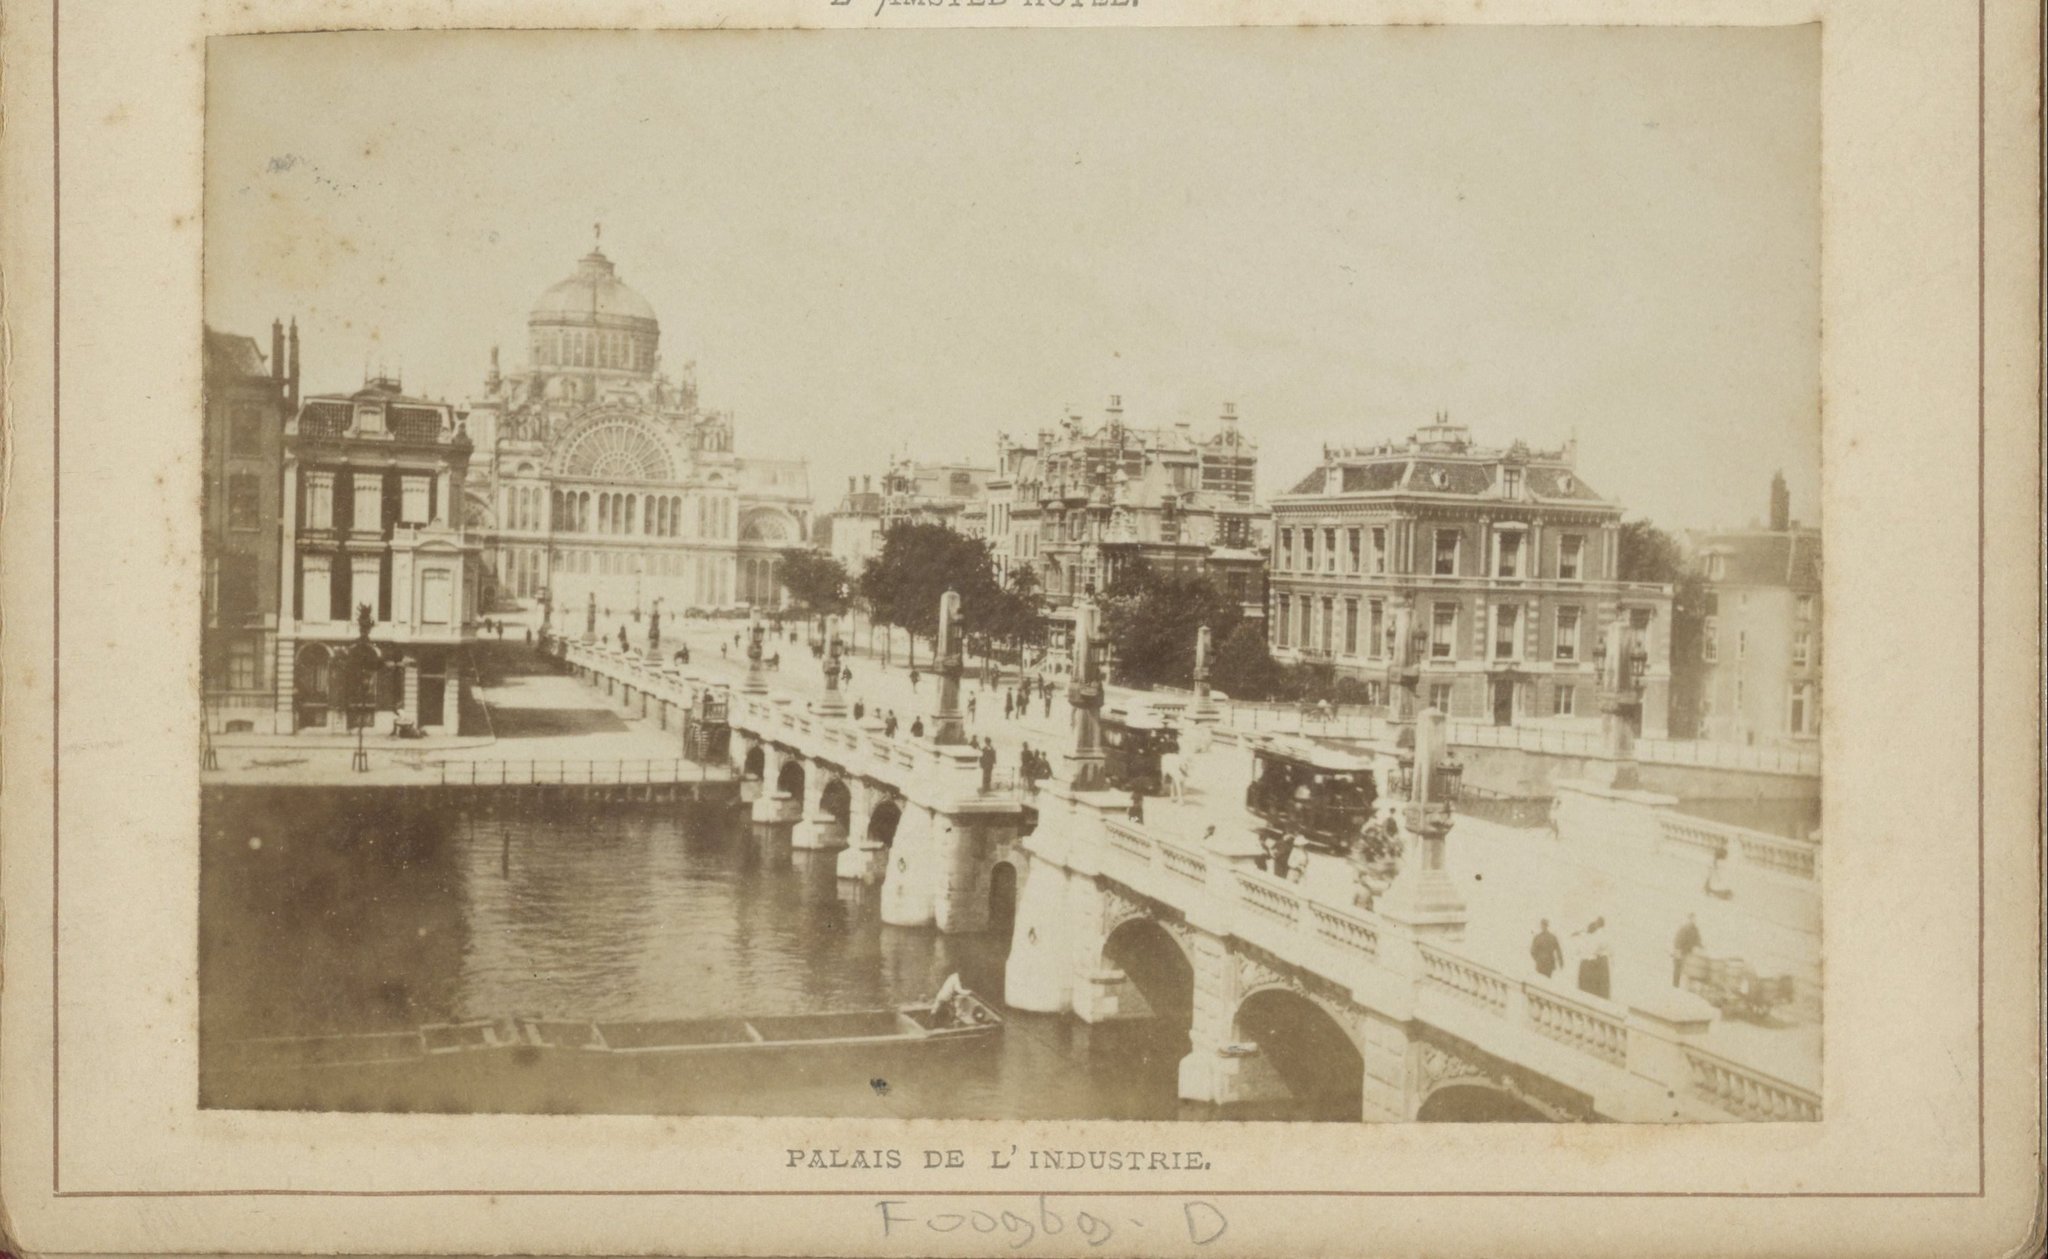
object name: photograph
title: Palais de l'Industrie.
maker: andries jager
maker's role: publisher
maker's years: 1825-1905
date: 1883-1910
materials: cardboard, paper, photographic support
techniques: albumen print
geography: amsterdam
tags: diligence, omnibus, horse-tram, palace, bridge in city across river, canal, etc., dome ~ architecture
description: Onderdeel van Leporelloalbum met 28 foto's van Amsterdam en omstreken.